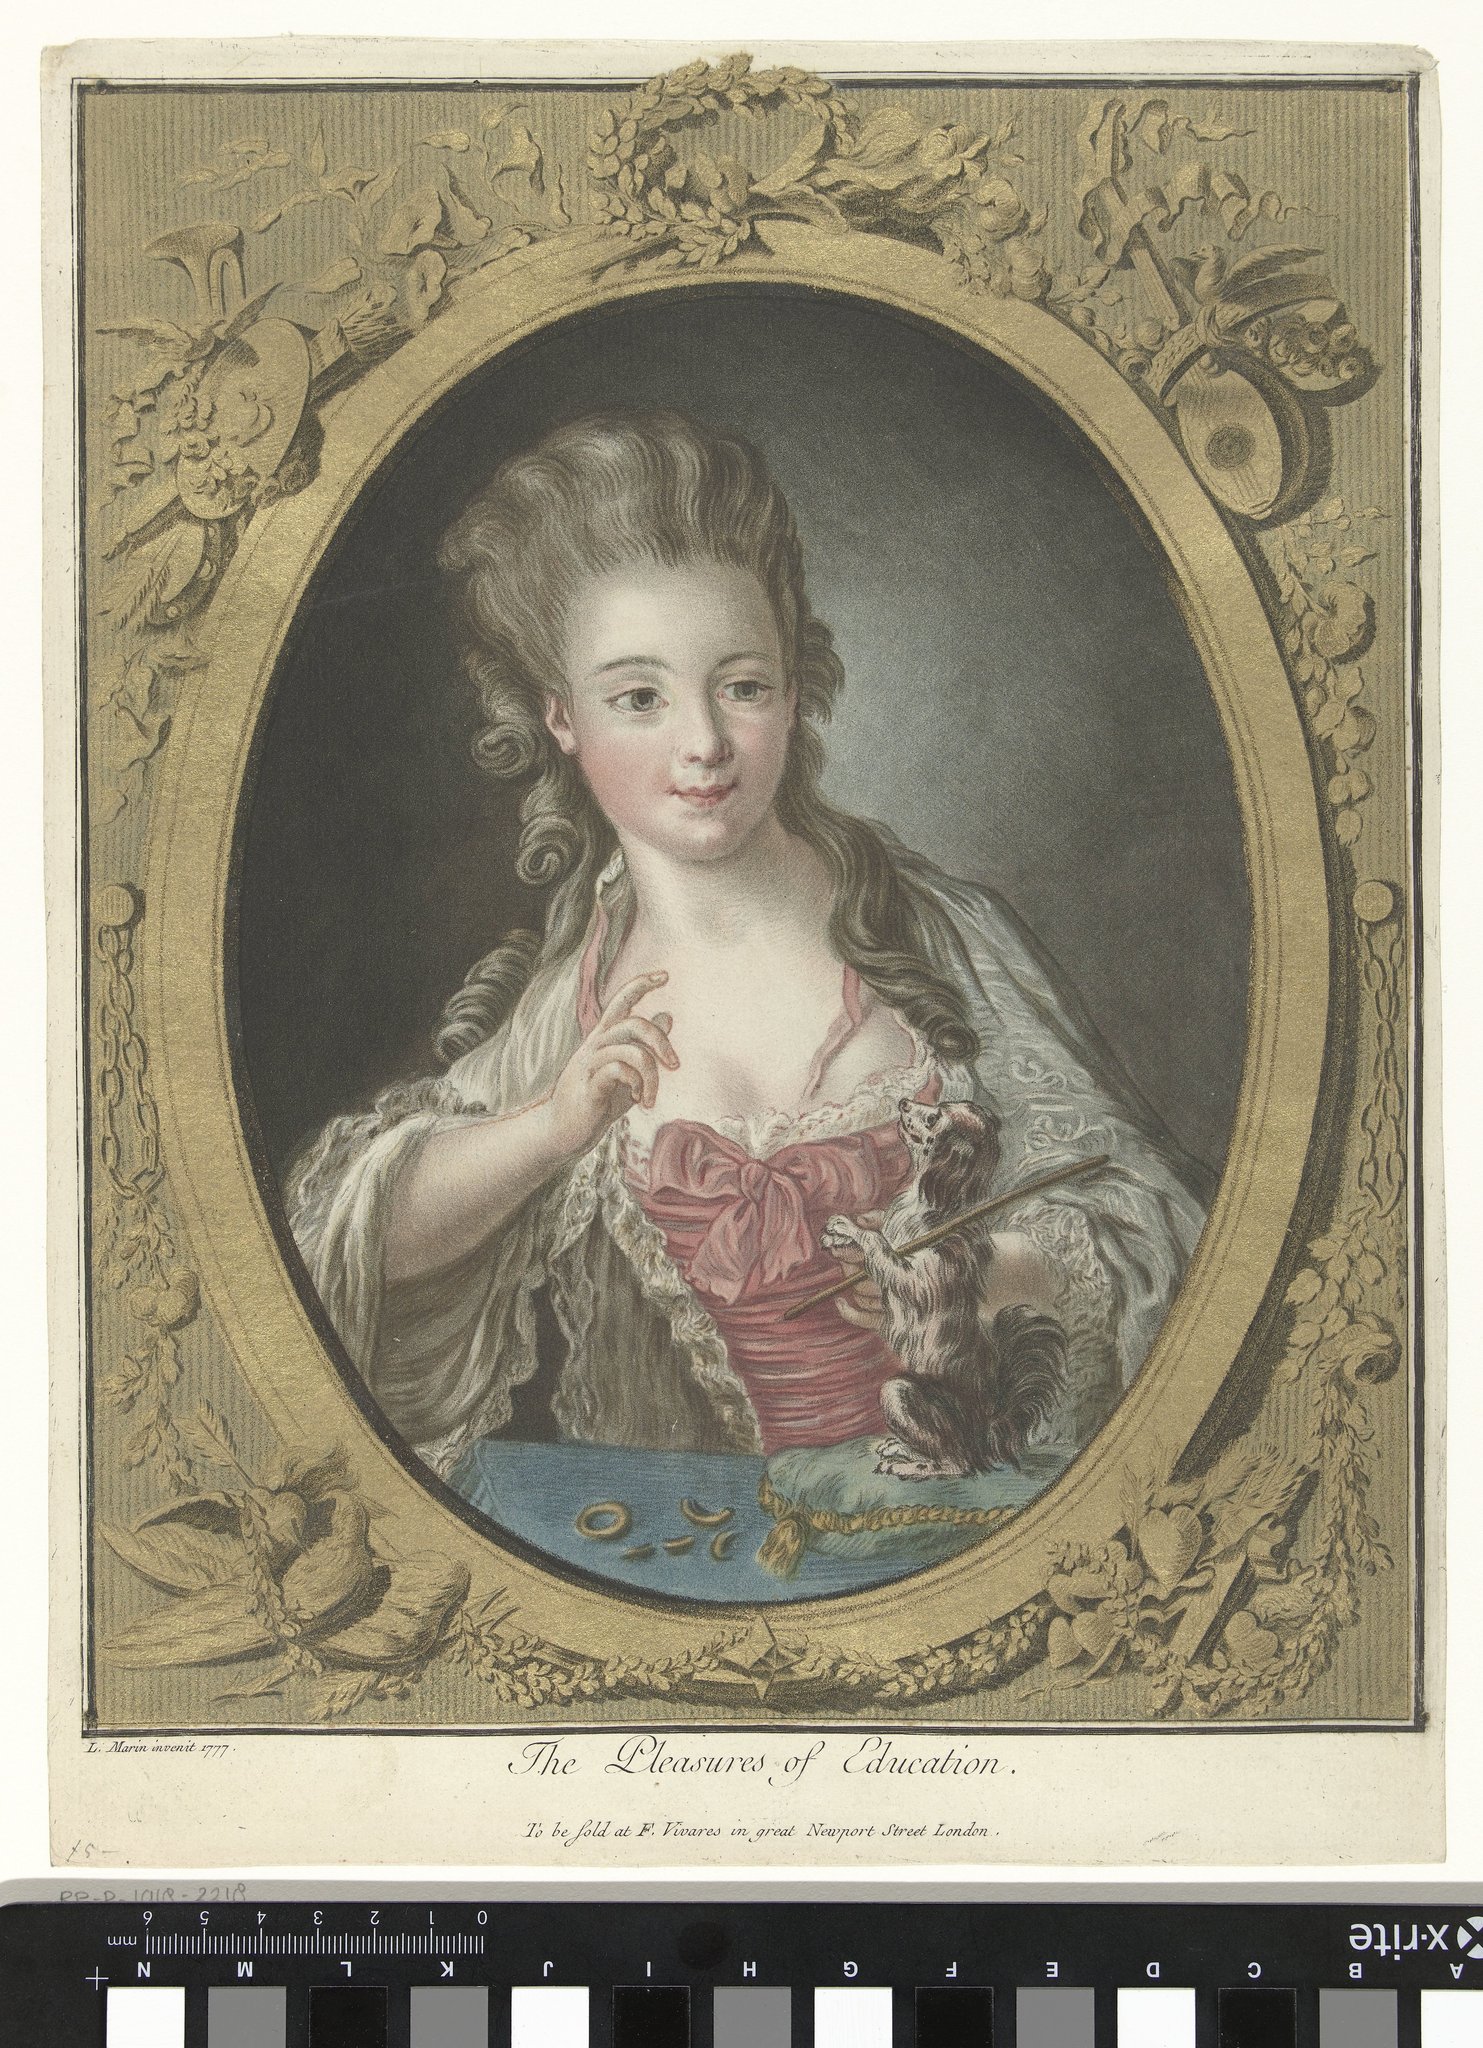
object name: print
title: The Pleasures of Education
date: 1777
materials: paper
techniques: drawing, etching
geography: london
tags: adolescent, young woman, maiden, training of dogs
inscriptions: collector's mark: Lugt 2233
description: Een jonge vrouw leert een hondje op de achterpoten te zitten. Stukjes koek liggen voor haar op de tafel. In een ovale omlijsting gedecoreerd met bloemen, muziekinstrumenten, twee tortelduiven, pijlen en harten.